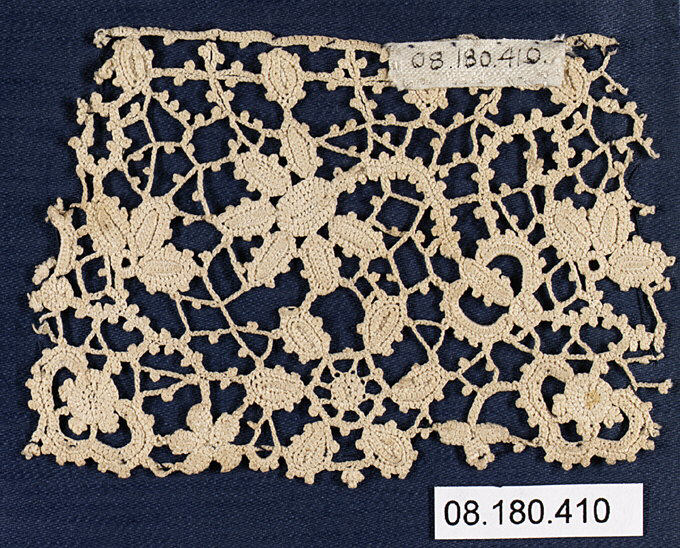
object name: fragment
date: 1801-1900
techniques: crochet